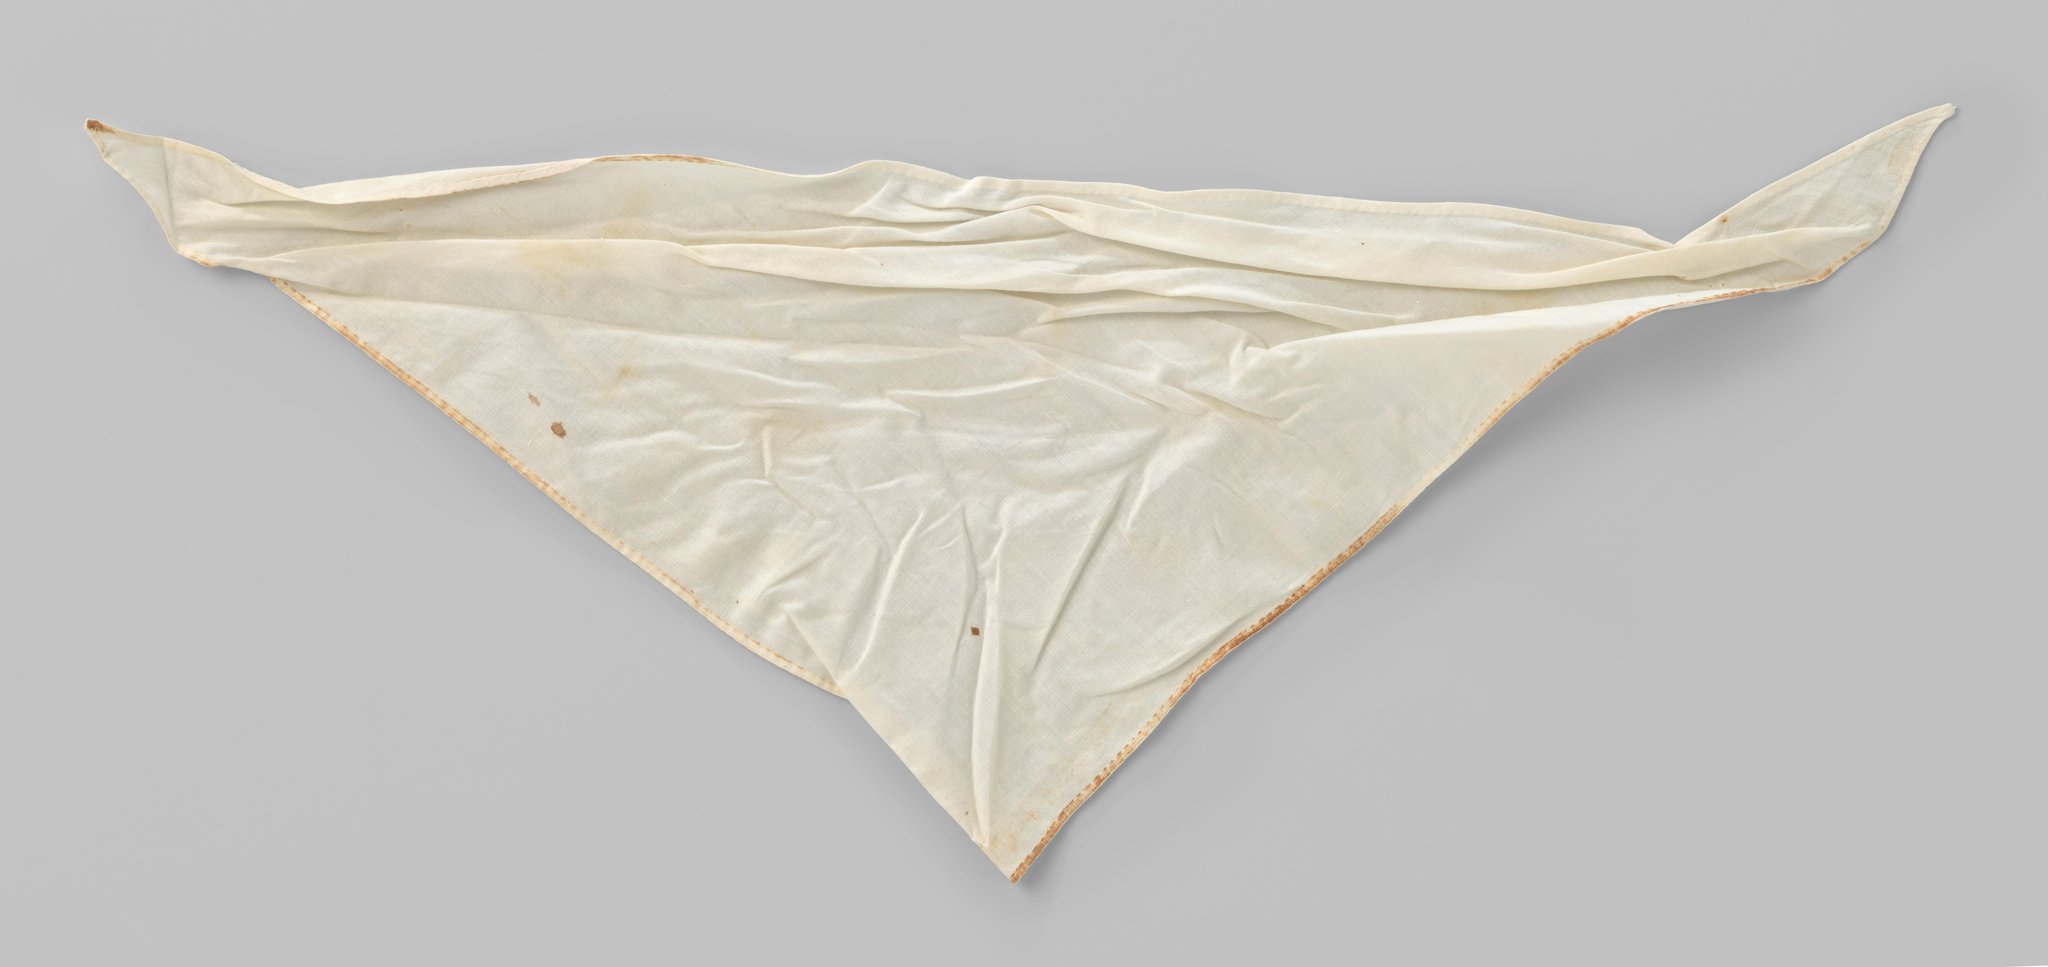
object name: fichu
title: Fichu van effen wit linnen voor pop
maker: Anonymous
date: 1850-1920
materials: linen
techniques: weave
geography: netherlands